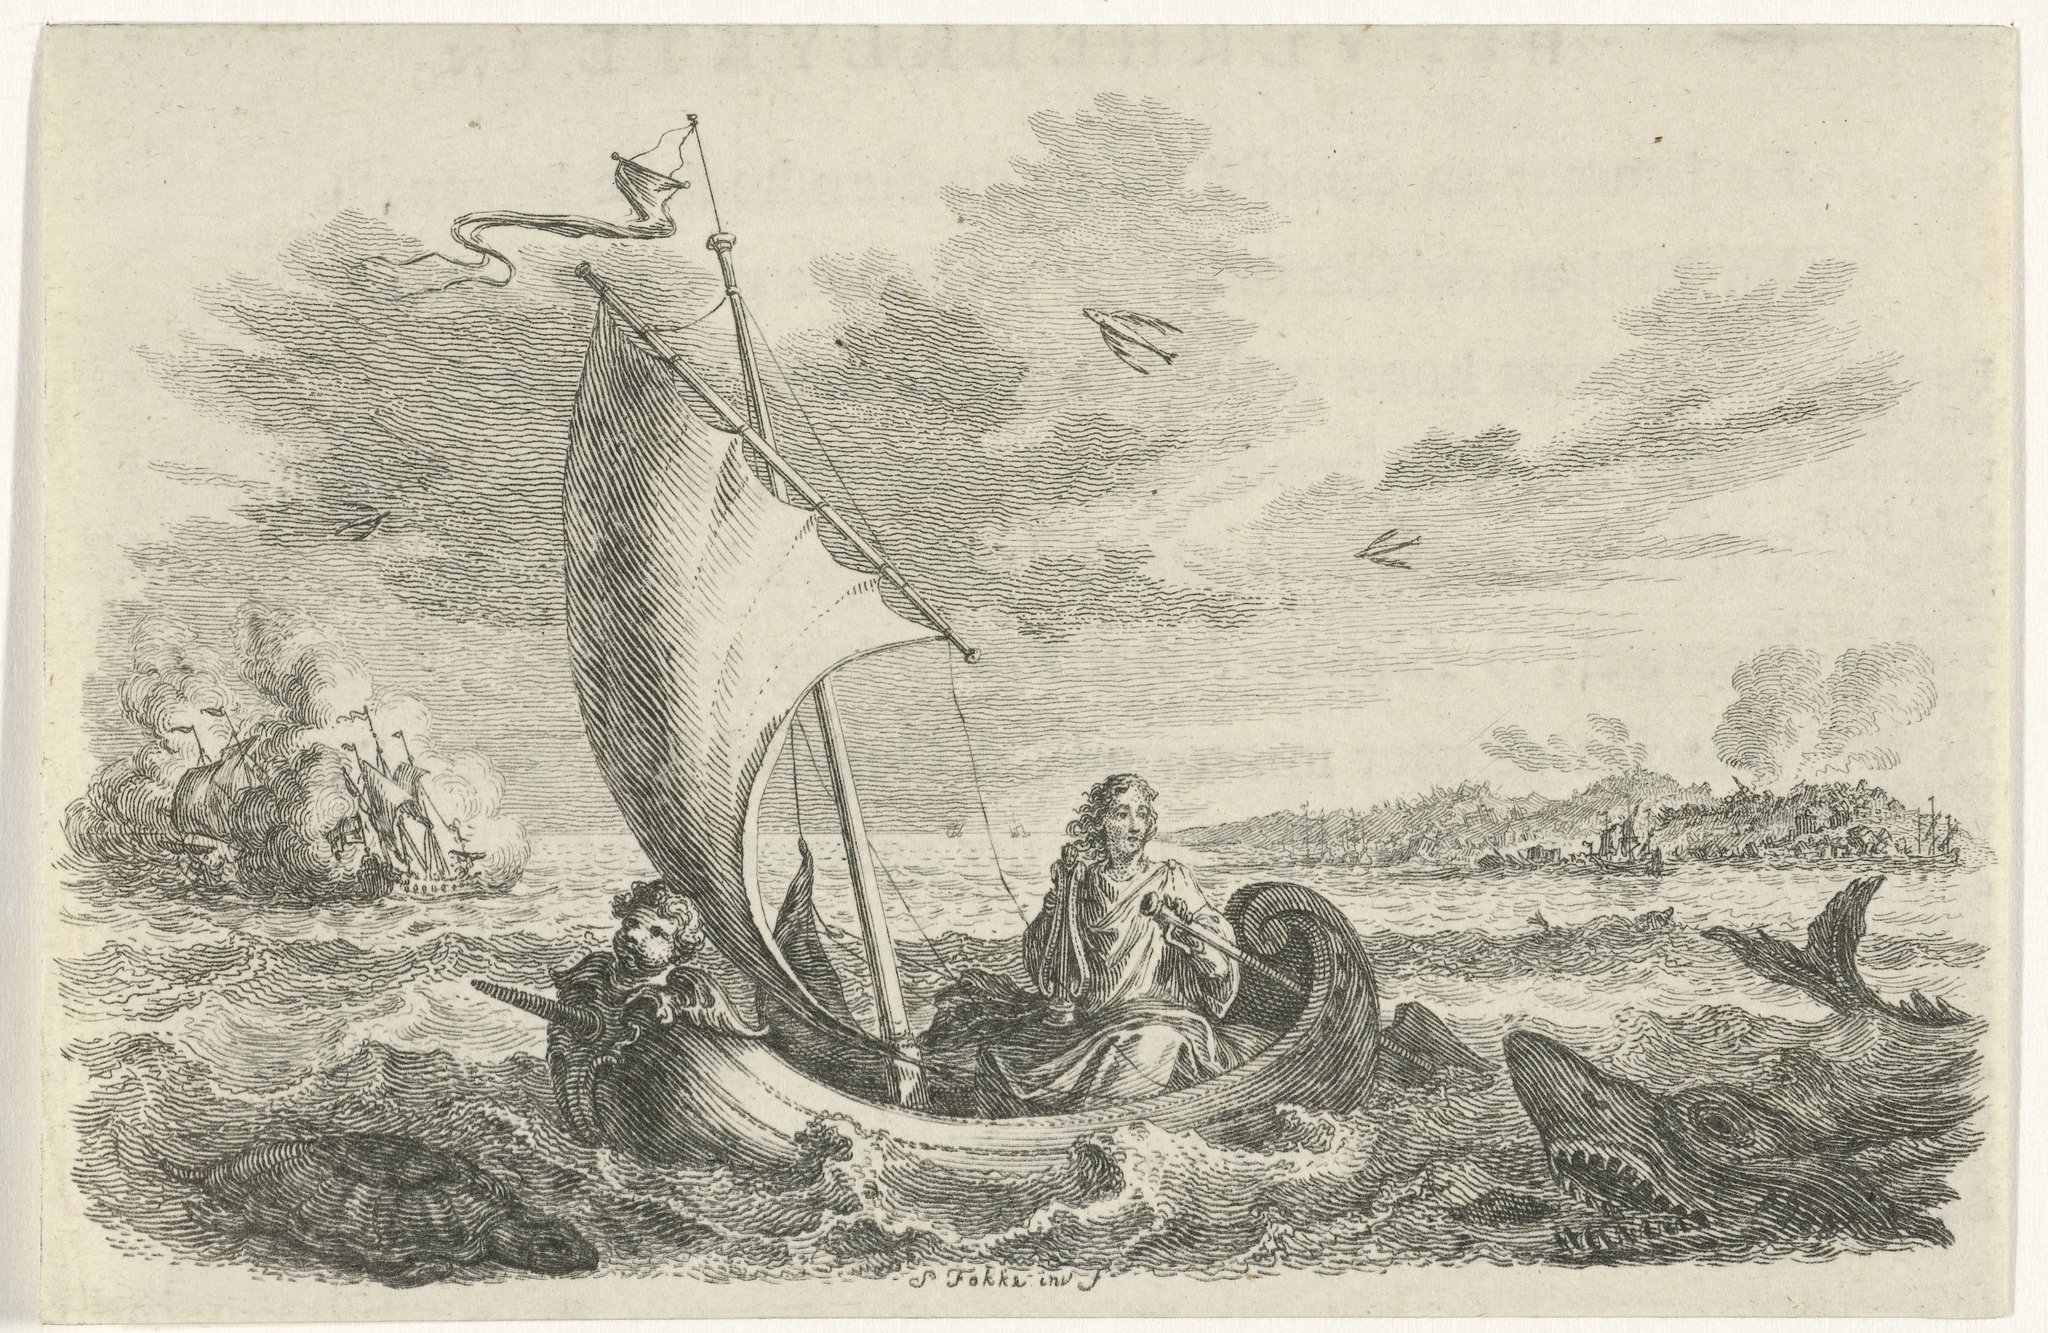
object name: print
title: Jongeman in een zeilboot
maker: simon fokke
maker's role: draughtsman, print maker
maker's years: 1712-1784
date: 1722-1782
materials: paper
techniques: etching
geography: amsterdam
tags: sailing-ship, sailing-boat, tortoises, turtles, lyre, cithara, psaltery, cartilaginous fishes: shark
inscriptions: collector's mark: Lugt 2228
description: Een jongeman vaart in een zeilboot en houdt een lier vast. Rond zijn boot zwemmen een vis en een schildpad. In de verte vindt een zeeslag plaats.